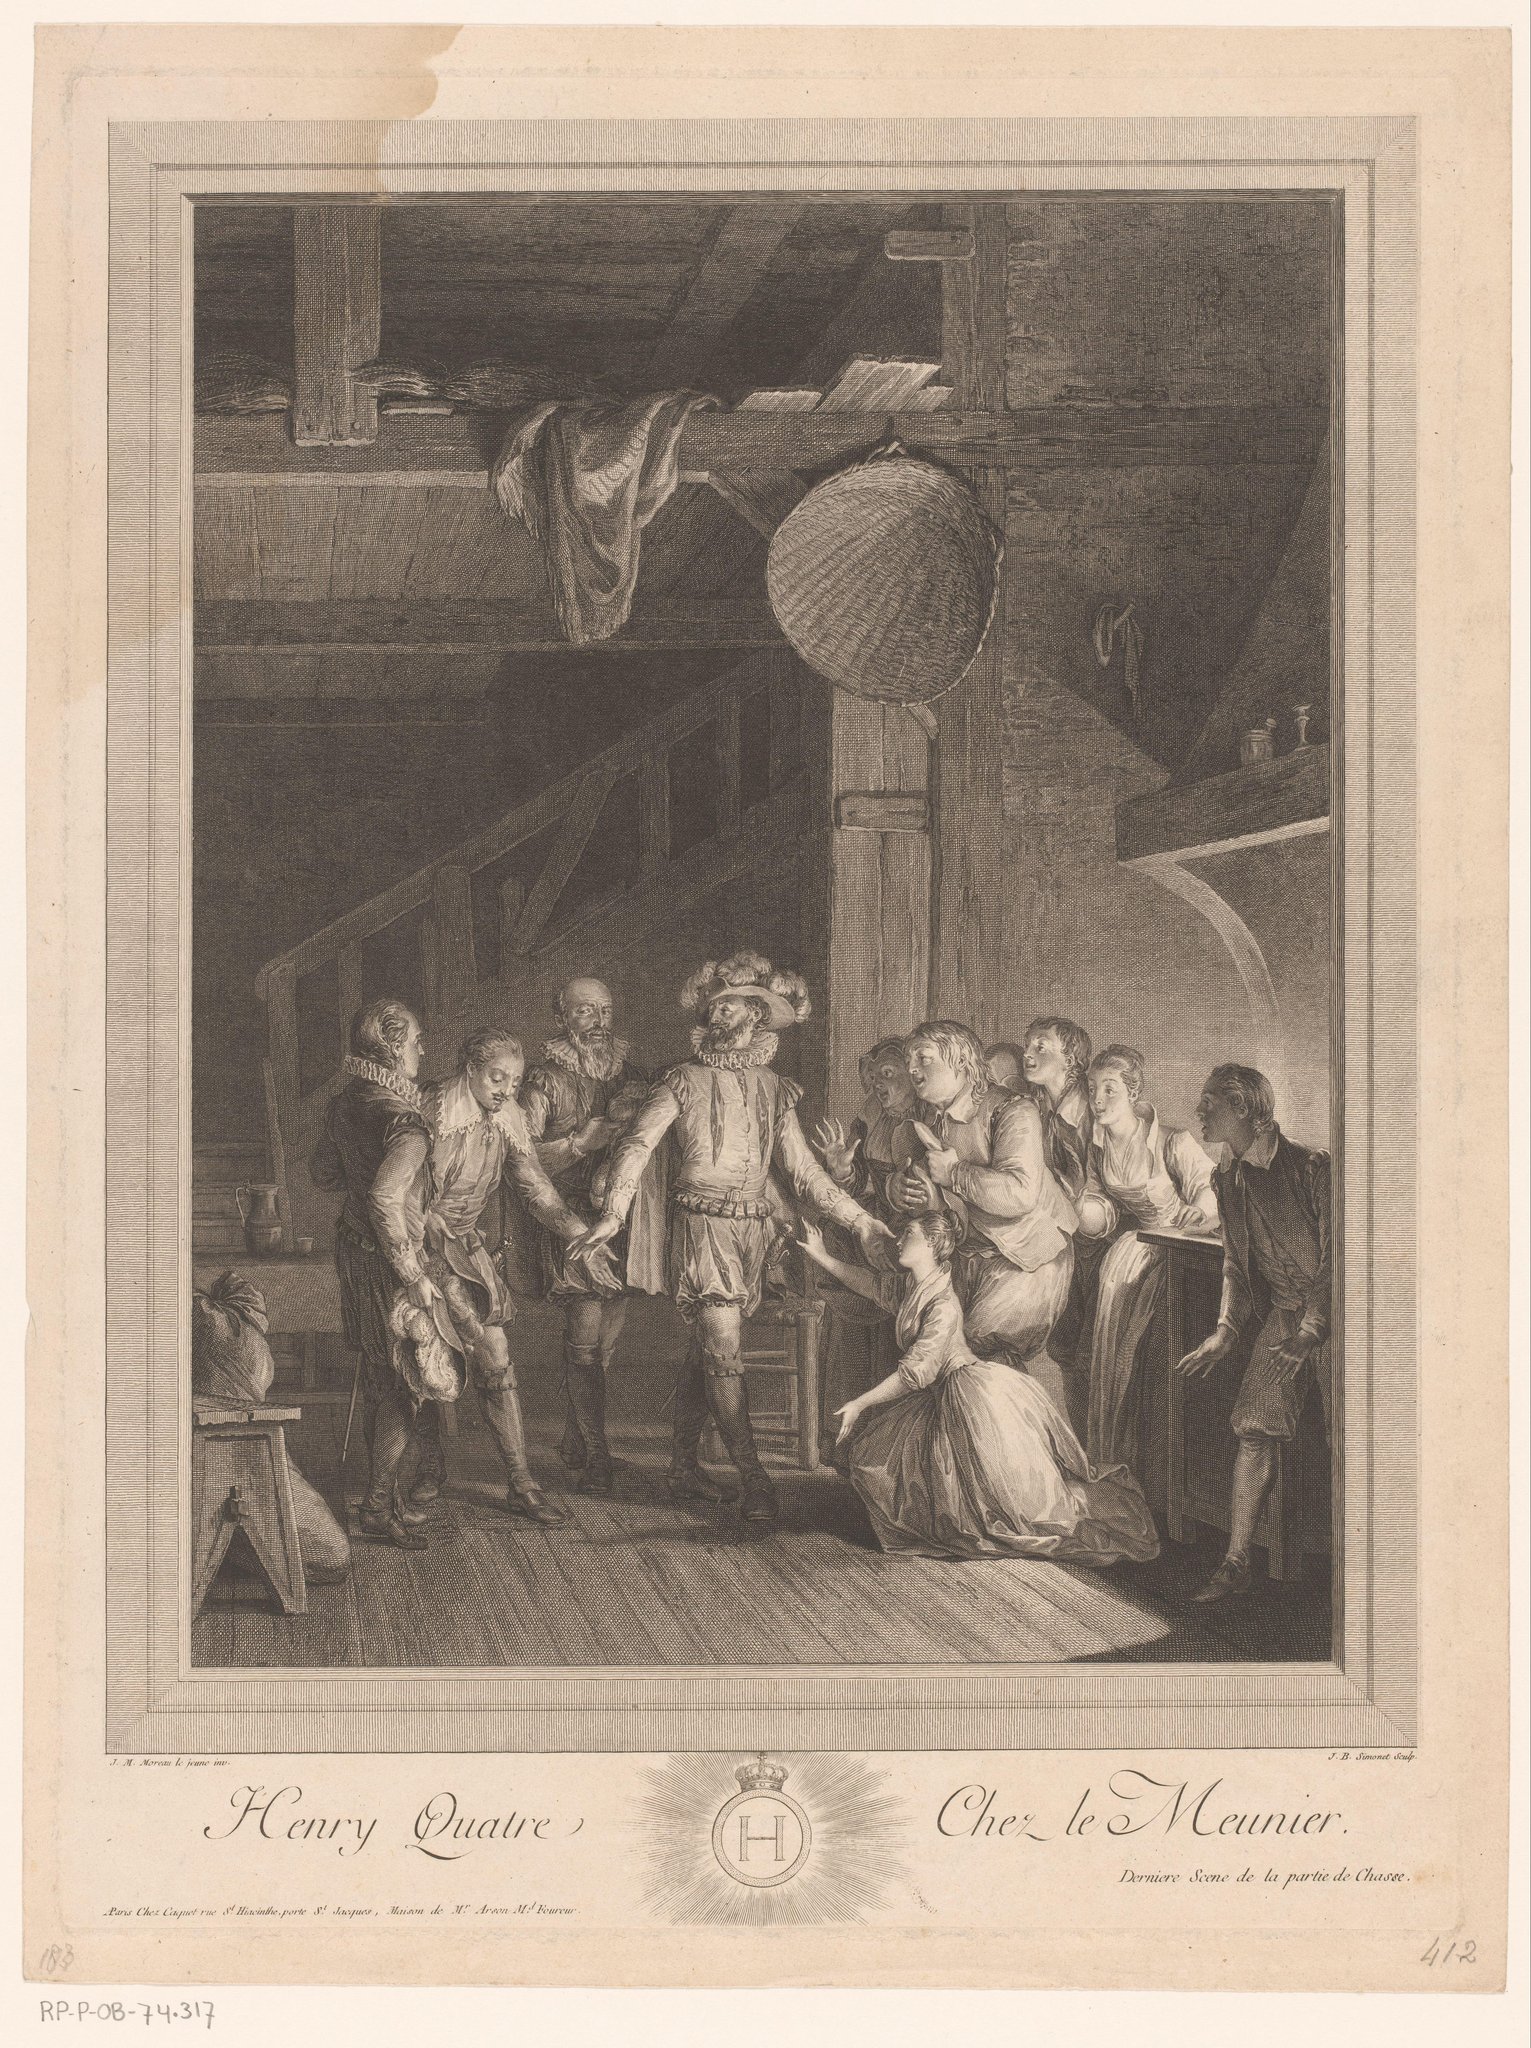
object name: print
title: Koning Hendrik IV bij de molenaar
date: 1752-1813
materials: paper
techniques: engraving, etching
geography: paris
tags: hendrik iv (koning van frankrijk en navarra), miller, historical persons, king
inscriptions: collector's mark: Lugt 2228